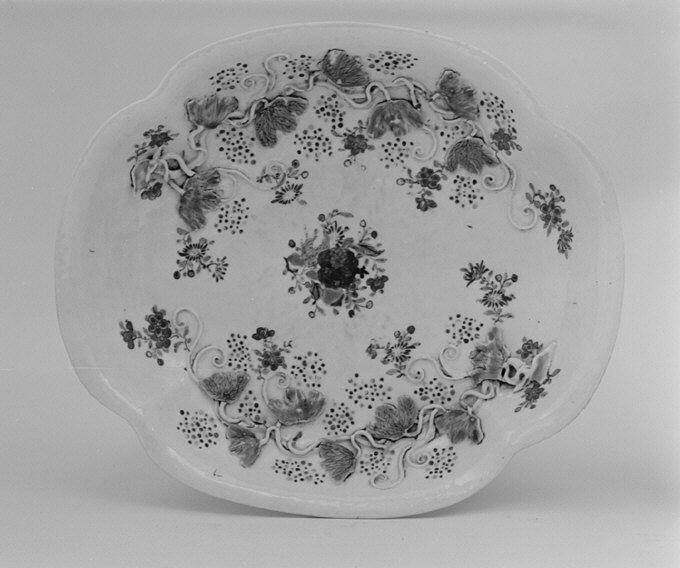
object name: stand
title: Stand (part of a set)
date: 1740-1770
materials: hard paste porcelain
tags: flowers